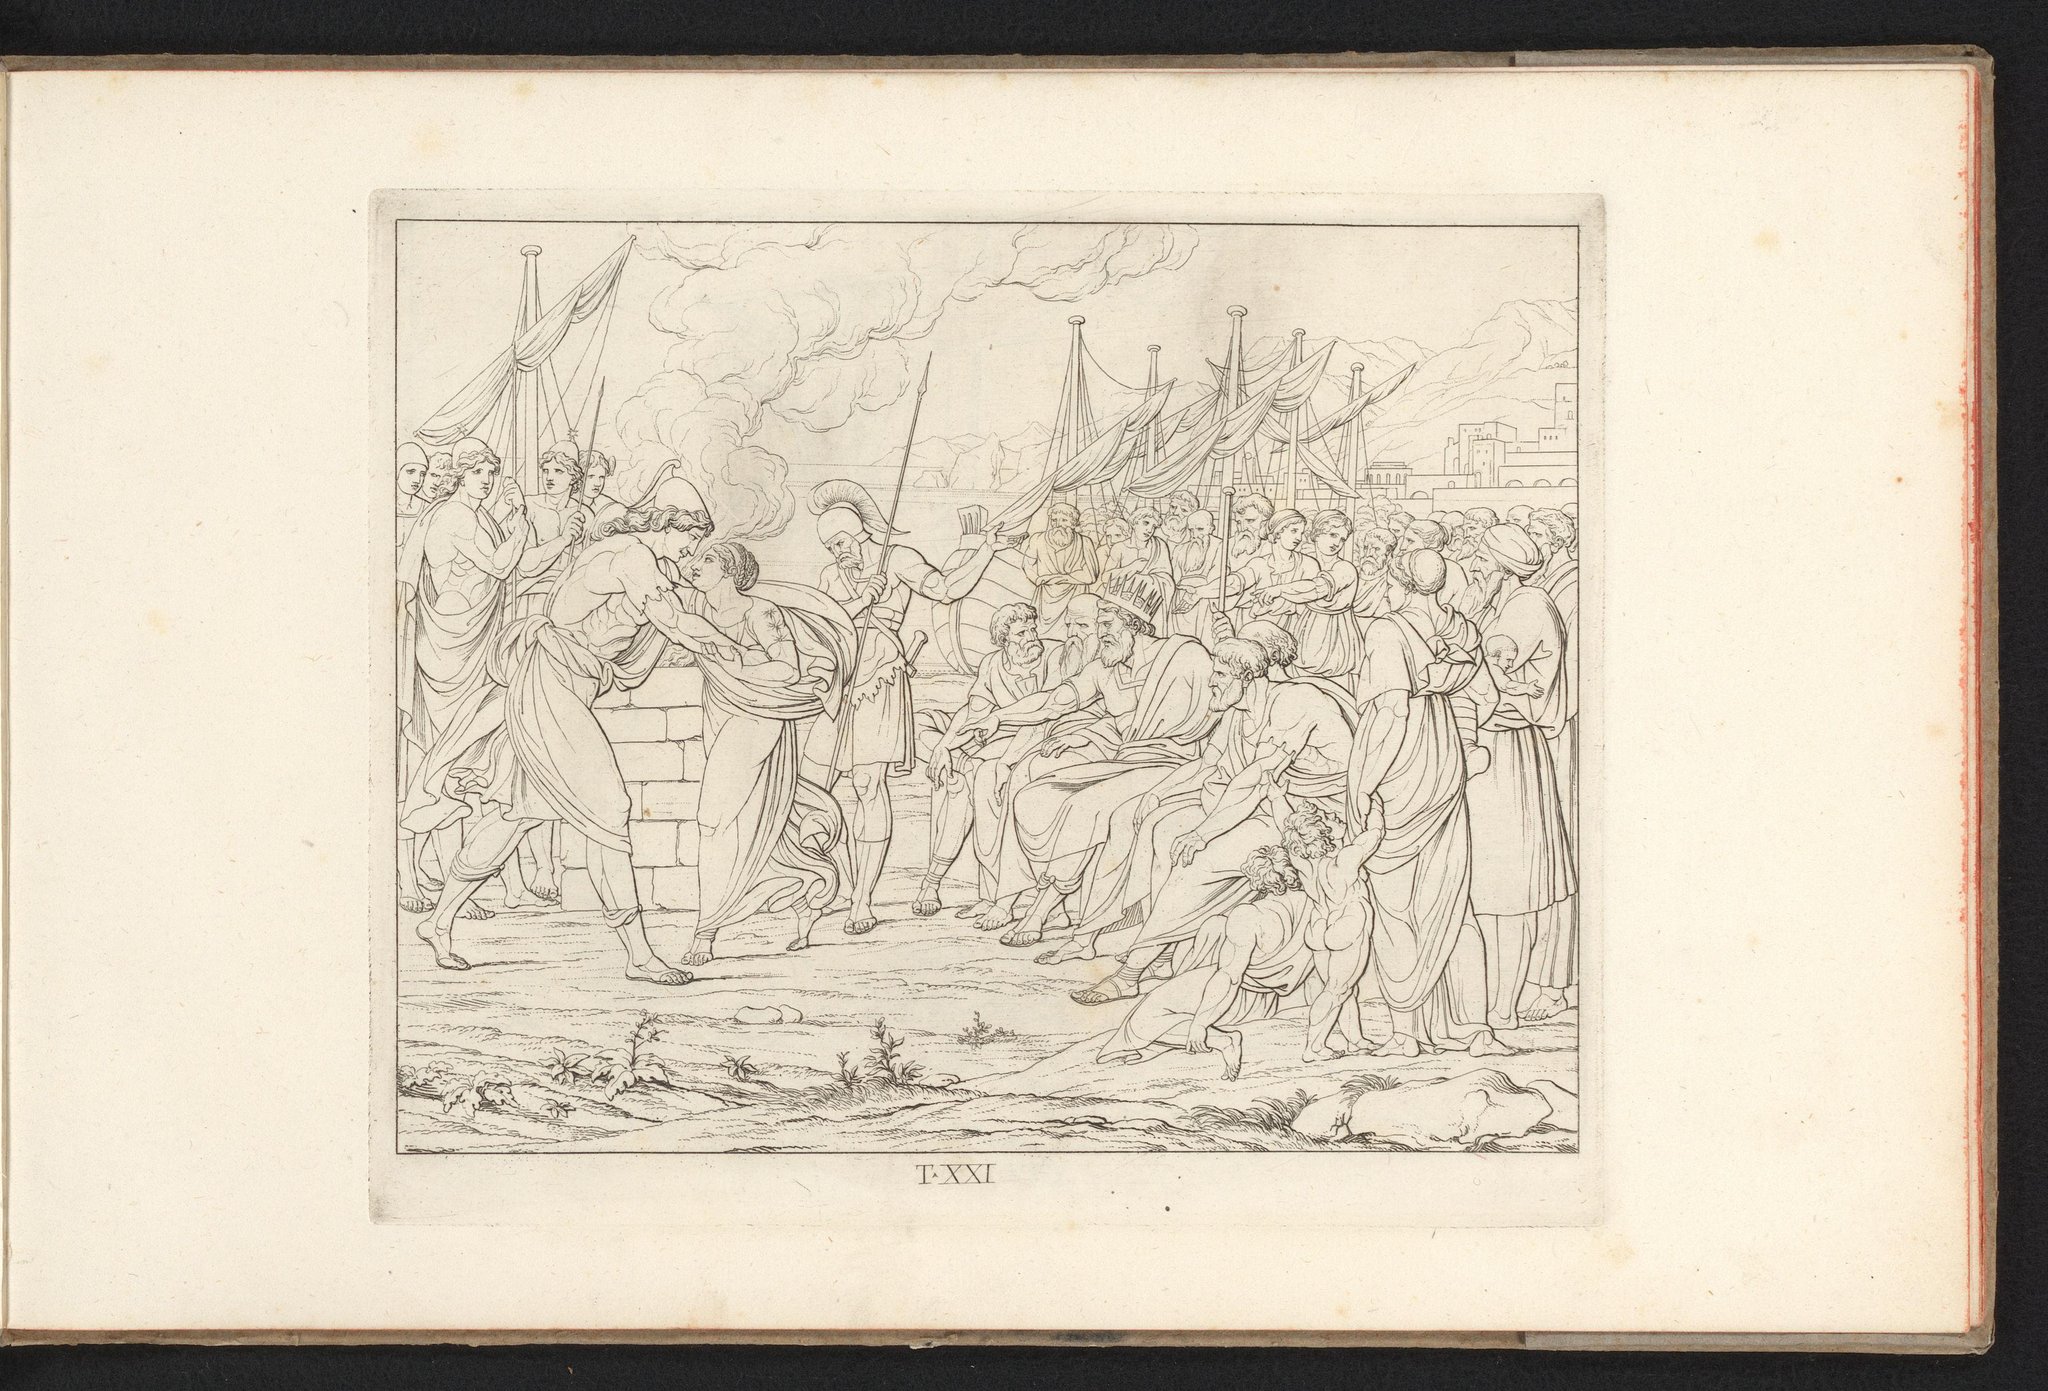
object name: album leaf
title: Les Argonautes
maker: joseph anton koch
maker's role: draughtsman, painter, print maker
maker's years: 1768-1839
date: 1799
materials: paper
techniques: etching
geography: rome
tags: the argonauts with alcinous, king of the phaeacians, wedding of jason and medea; the golden fleece is spread over the bed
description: Deze prent maakt deel uit van een serie met 24 prenten.